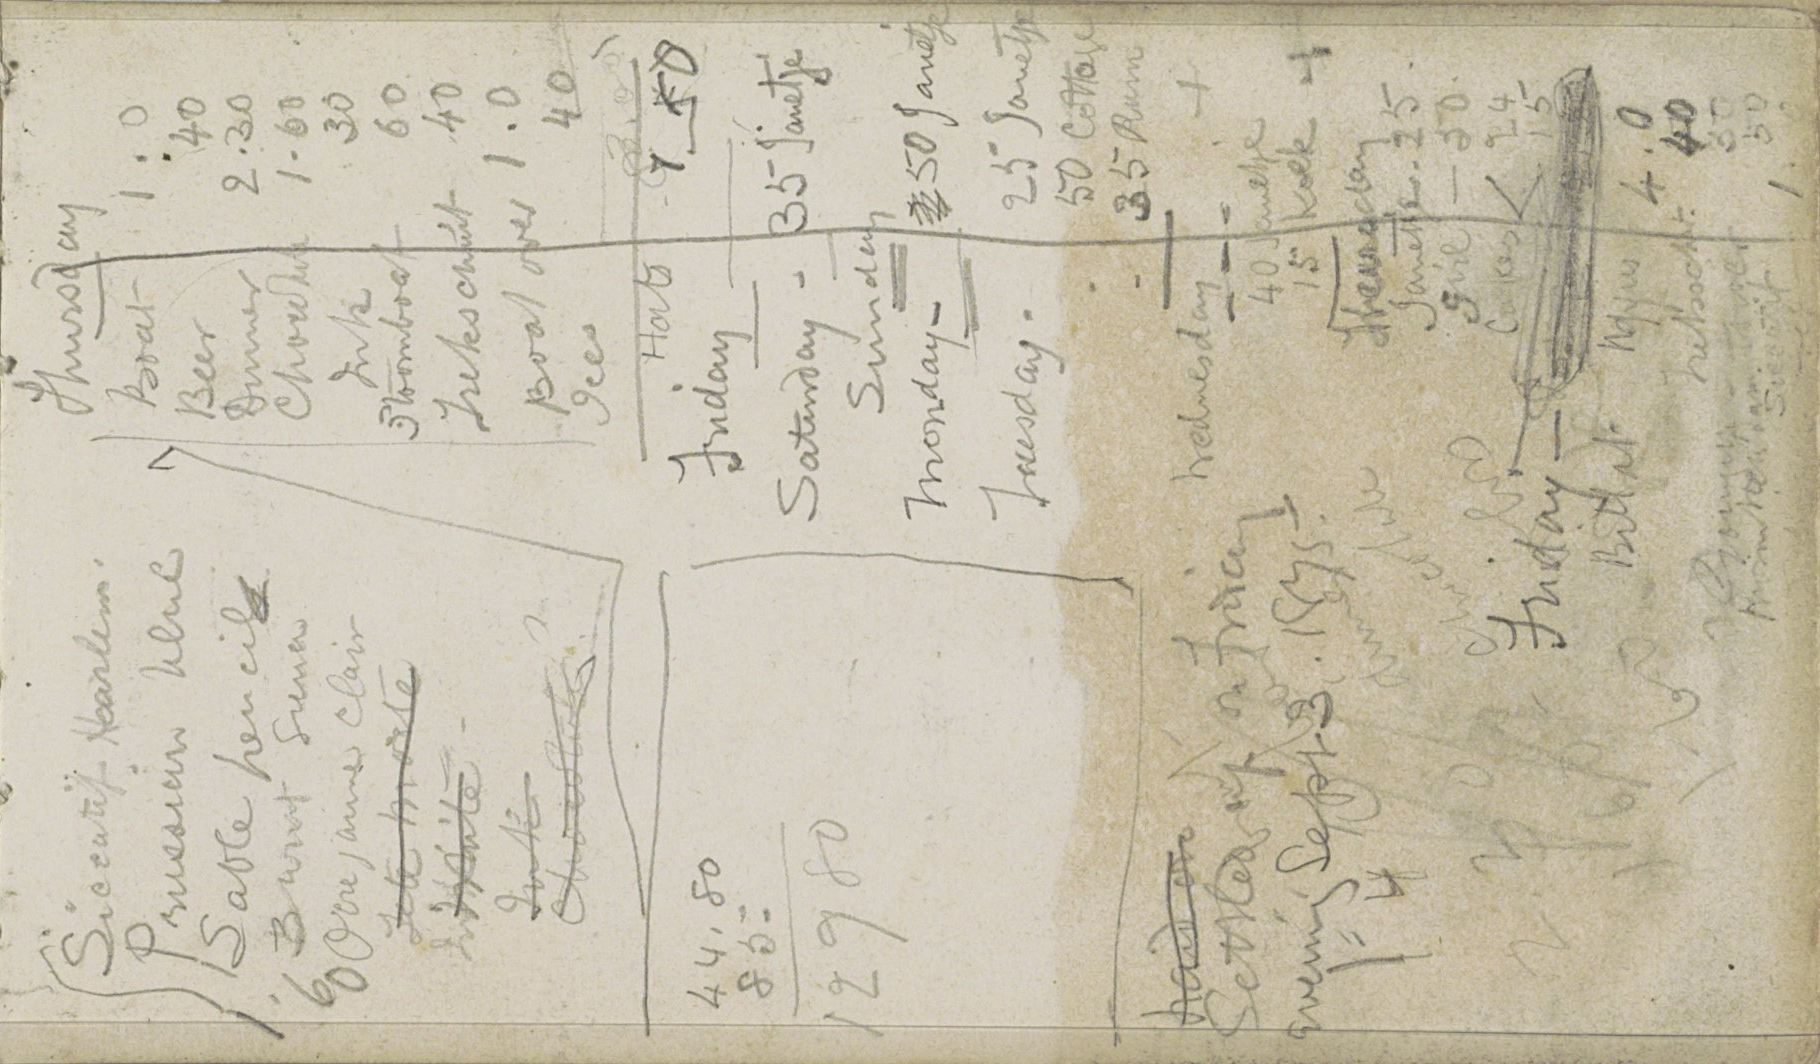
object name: sketchbook leaf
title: Reisnotities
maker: george clausen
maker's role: draughtsman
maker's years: 1852-1912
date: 1875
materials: paper, pencil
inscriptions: annotation: ‘[...]’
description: Blad 2 recto uit een schetsboek met 46 bladen.